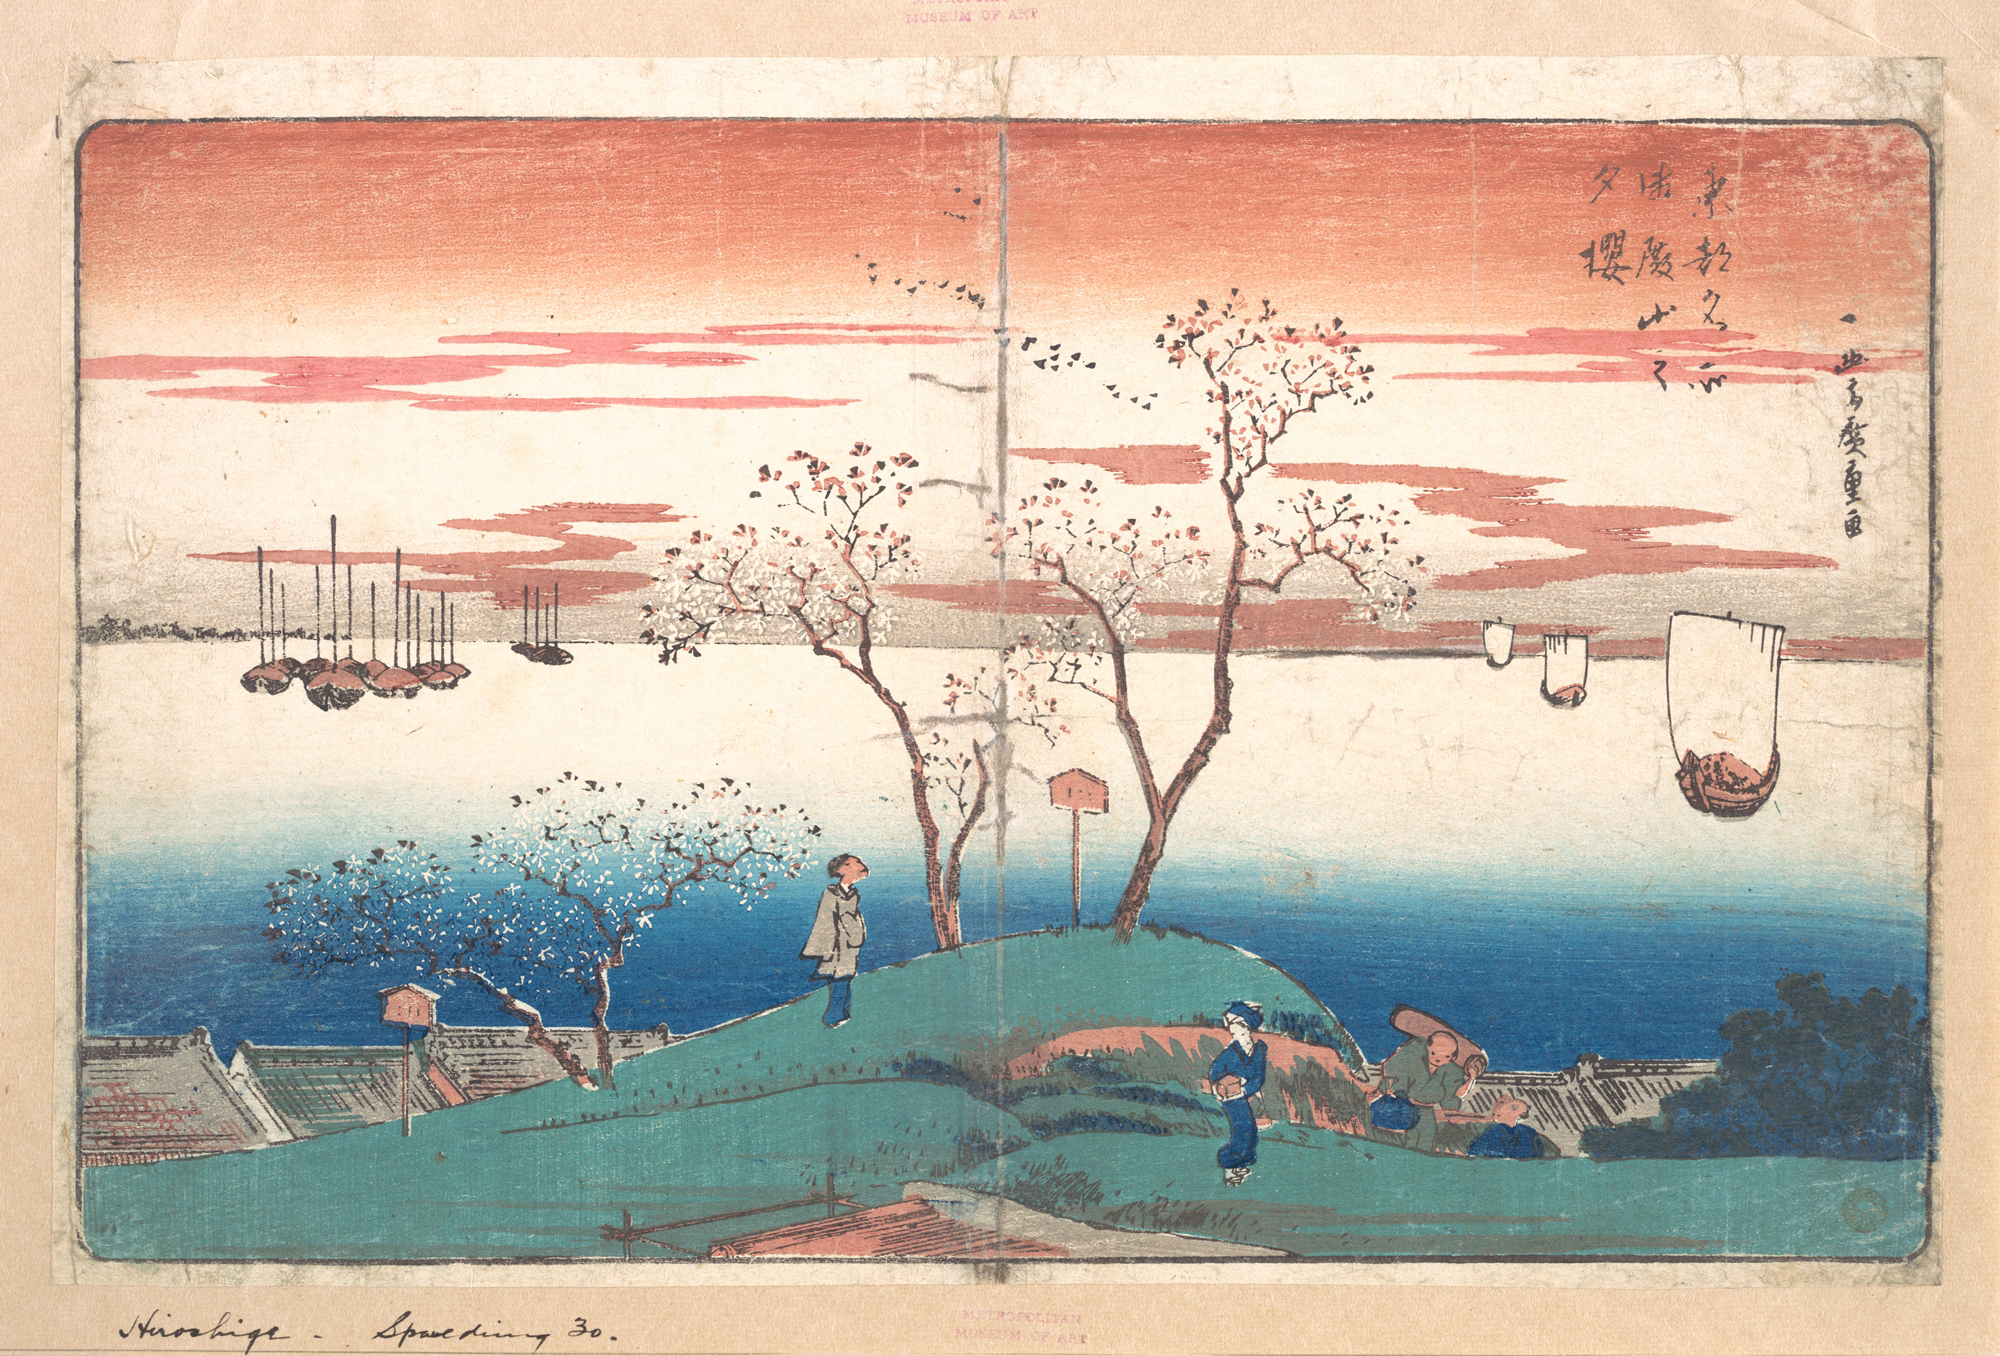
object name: print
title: Evening Cherries on Gotem Yama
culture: japanese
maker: utagawa hiroshige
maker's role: artist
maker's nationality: japanese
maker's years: 1797-1858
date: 1830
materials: ink, paper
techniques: woodblock print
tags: trees,boats